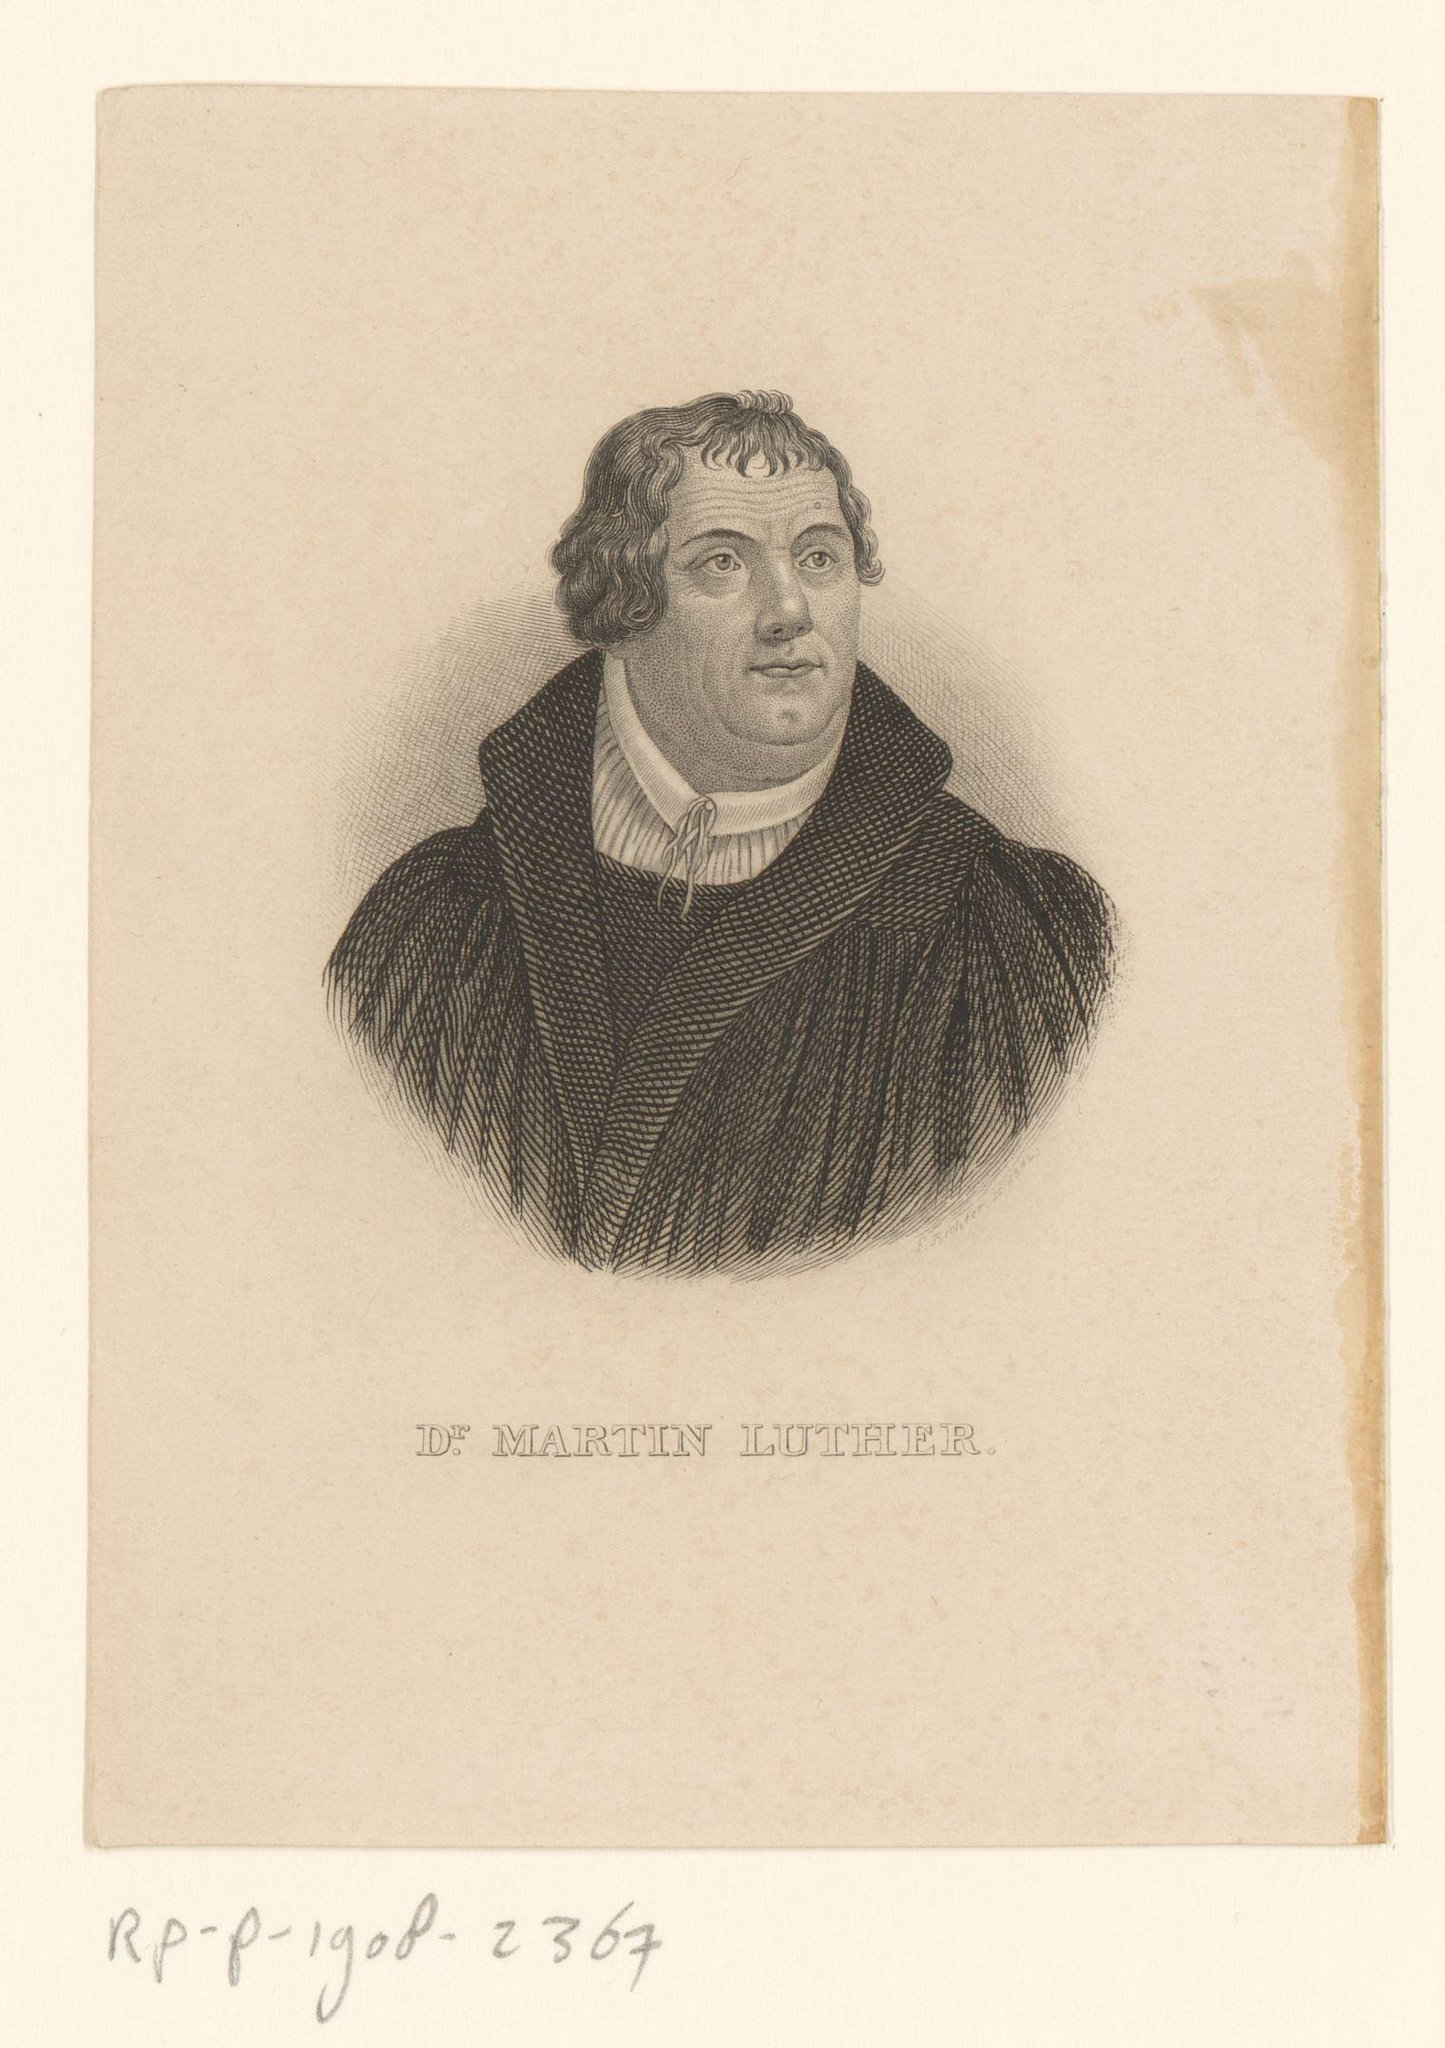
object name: print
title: Portret van Martin Luther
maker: f. richter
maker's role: print maker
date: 1800-1899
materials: paper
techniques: engraving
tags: priest, martin luther, theologian, historical persons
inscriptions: collector's mark: Lugt 2228